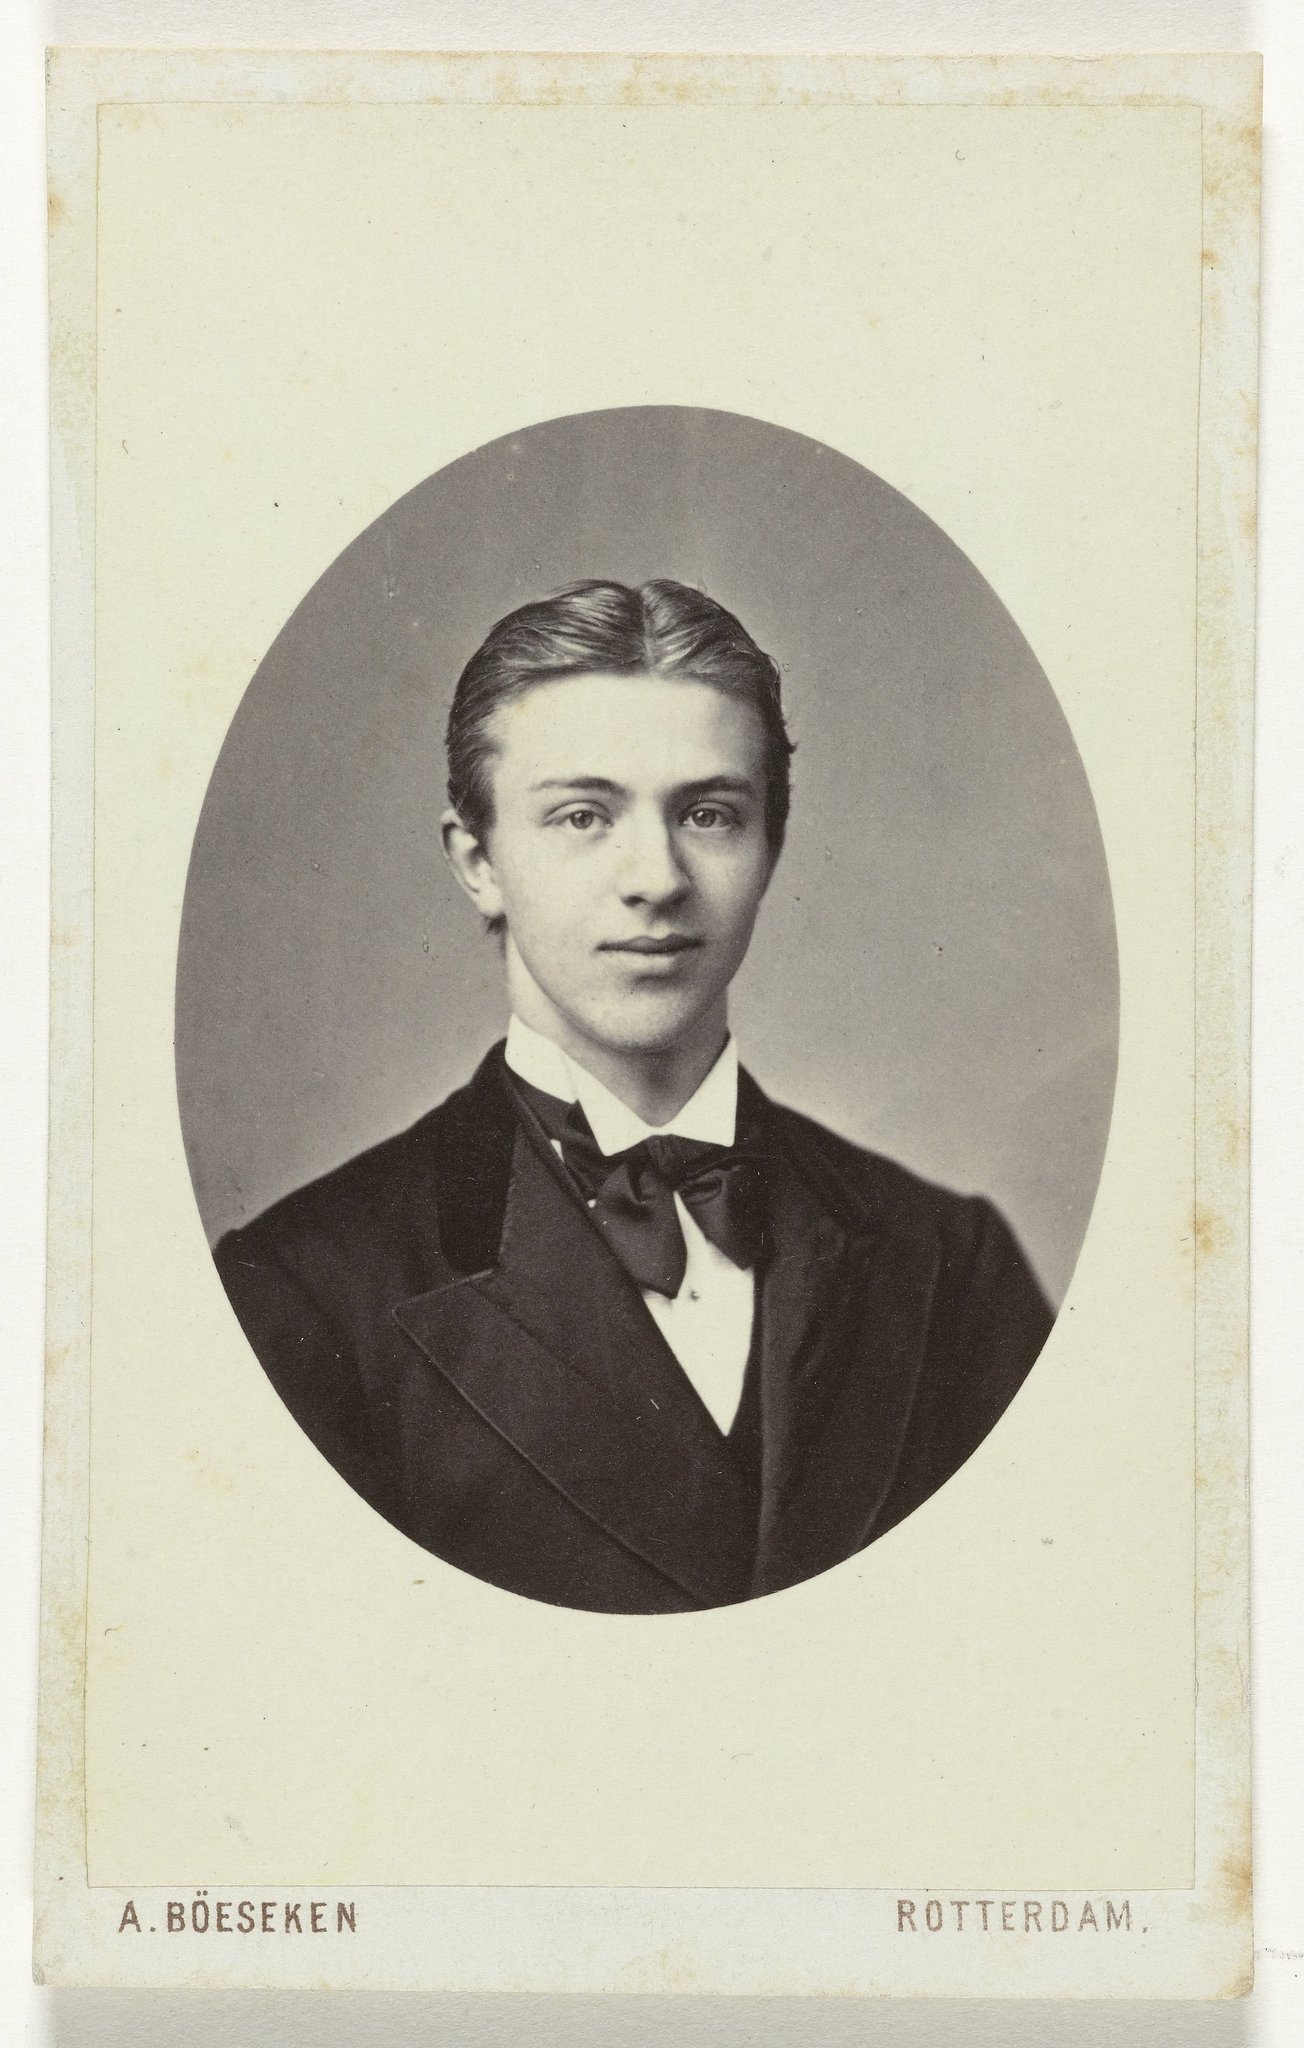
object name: carte de visite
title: Portret van een man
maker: a. böeseken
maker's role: fotograaf, lithograaf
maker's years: 1834-1919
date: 1870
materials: cardboard, paper, photographic support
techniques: albumen print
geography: rotterdam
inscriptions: address: ‘A. Böeseken/Photographisch Atelier/Rotterdam/Hoogstraat over de/Vlasmarkt’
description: Kop van een jonge man met haarscheiding in het midden, in ovaal, zonder achtergrond.